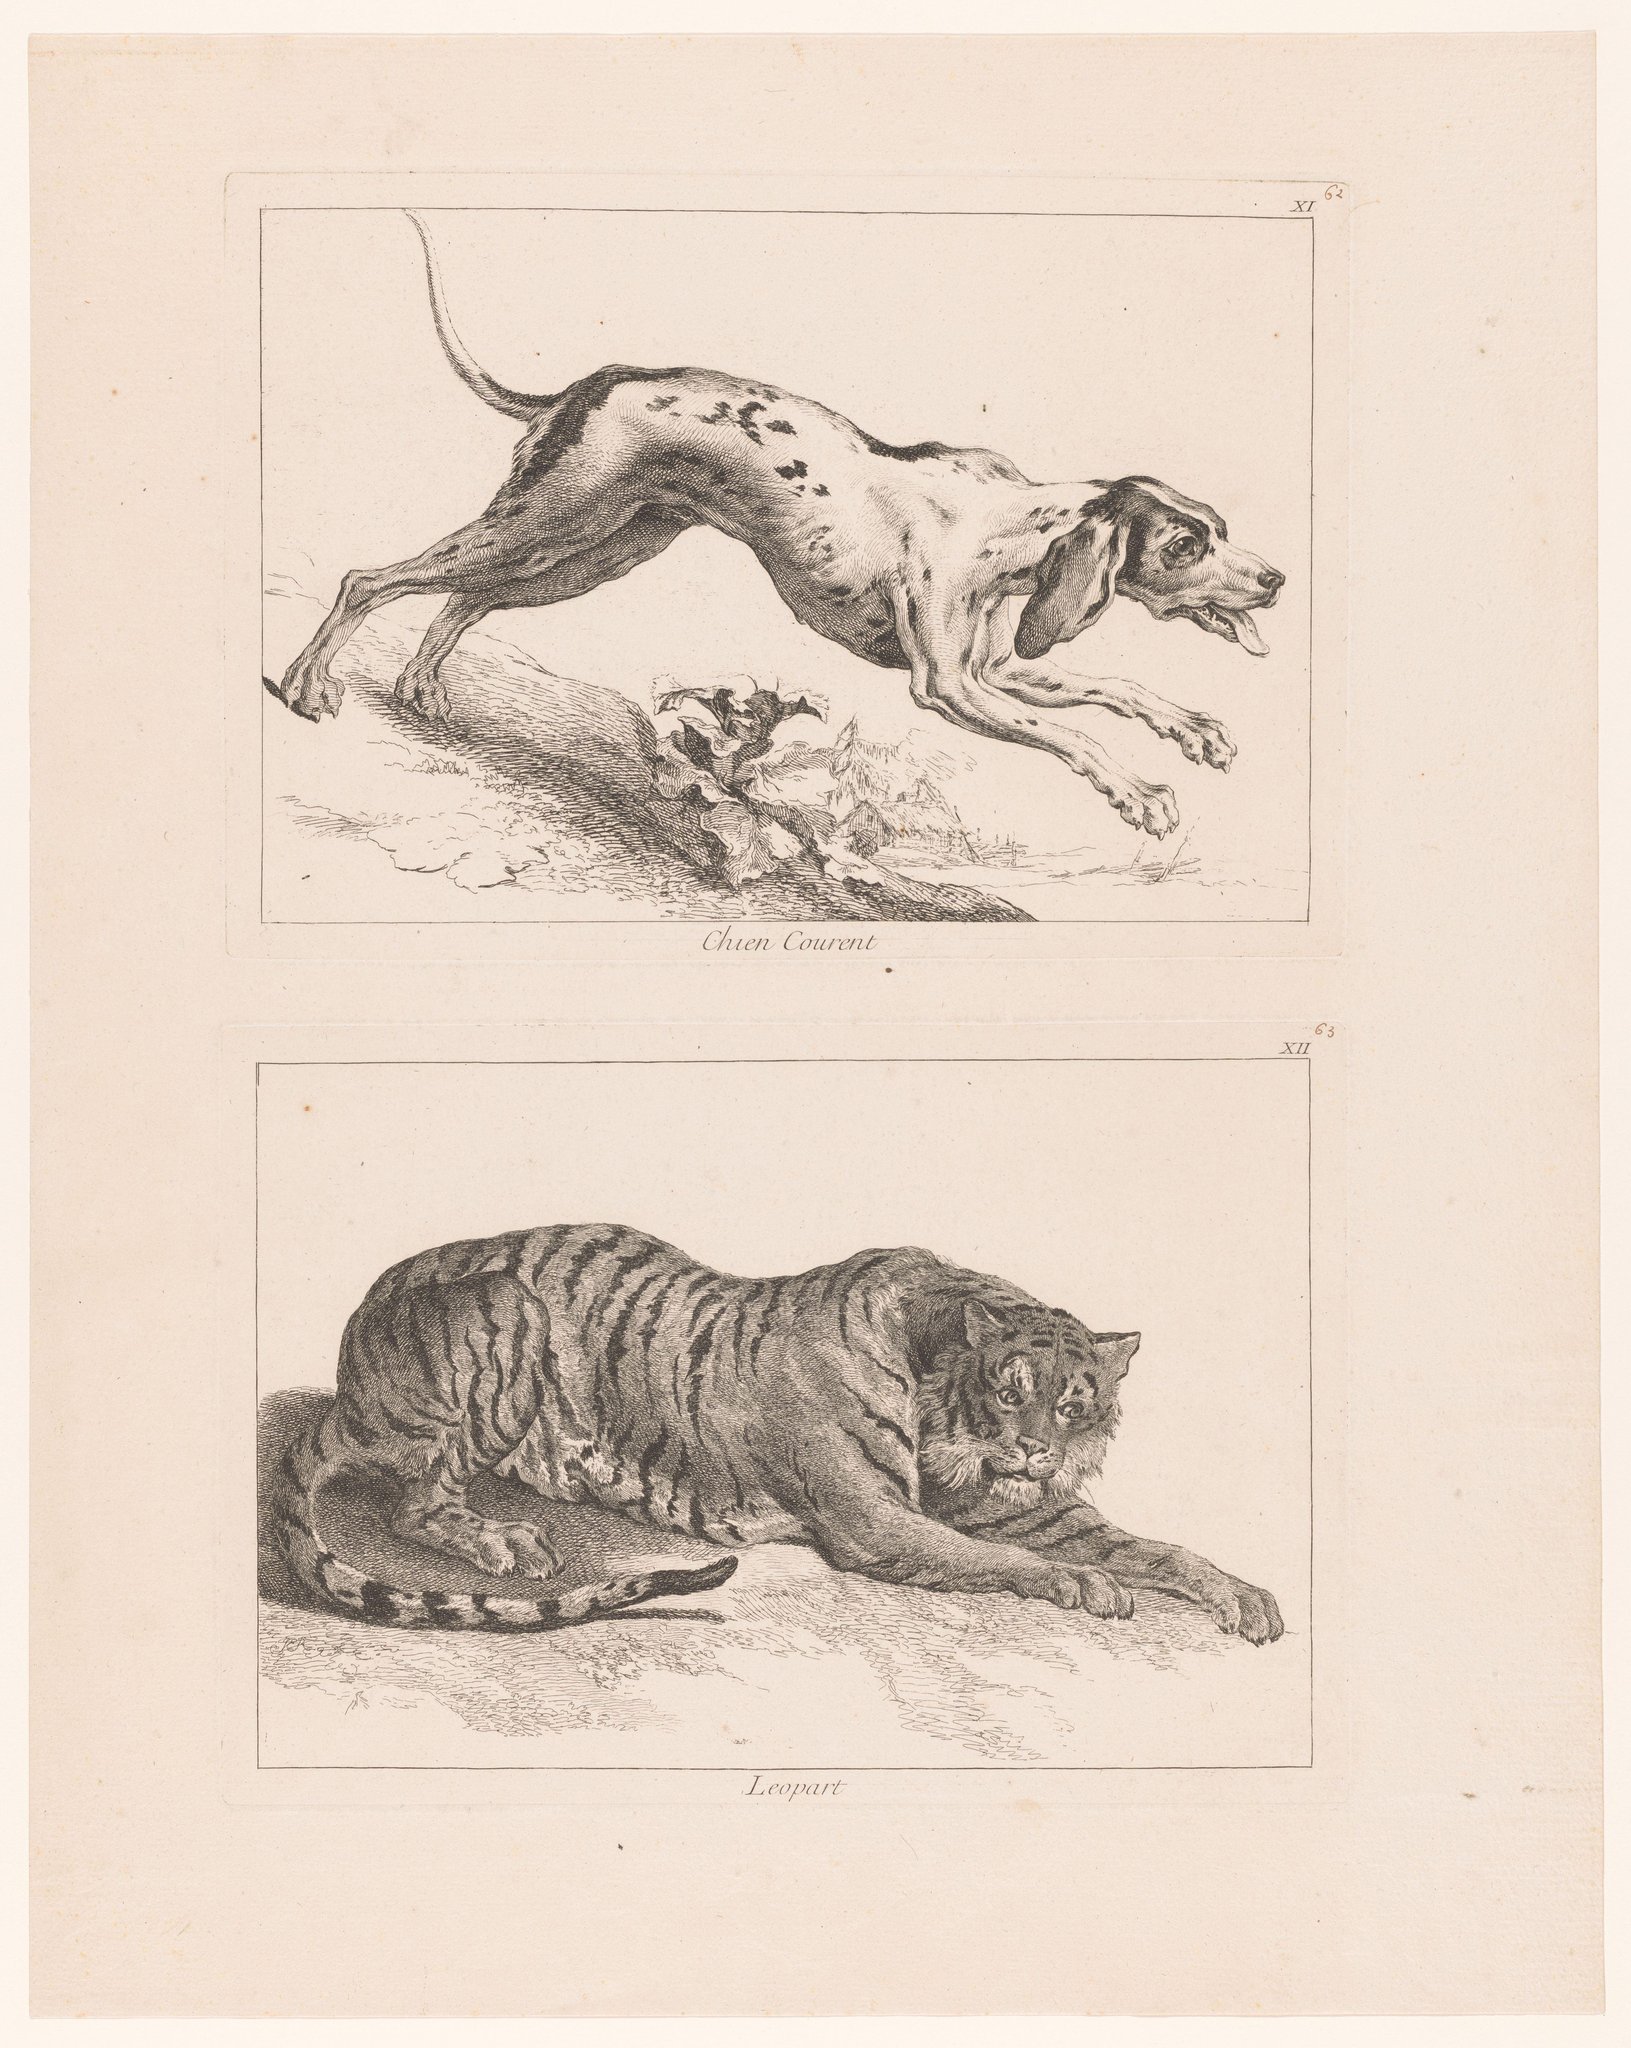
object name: print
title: Blad met twee platen: rennende hond en luipaard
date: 1740-1745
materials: paper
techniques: engraving, etching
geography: stockholm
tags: beasts of prey, predatory animals: tiger, beasts of prey, predatory animals: leopard, hunting dogs, dog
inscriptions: collector's mark: Lugt 240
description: Blad met twee platen. Bovenste plaat: een rennend jachthond (nr. XI). Onderste plaat: een luipaard of tijger (nr. XII). Onderdeel van een serie van twaalf prenten van dieren gerelateerd aan de jacht.